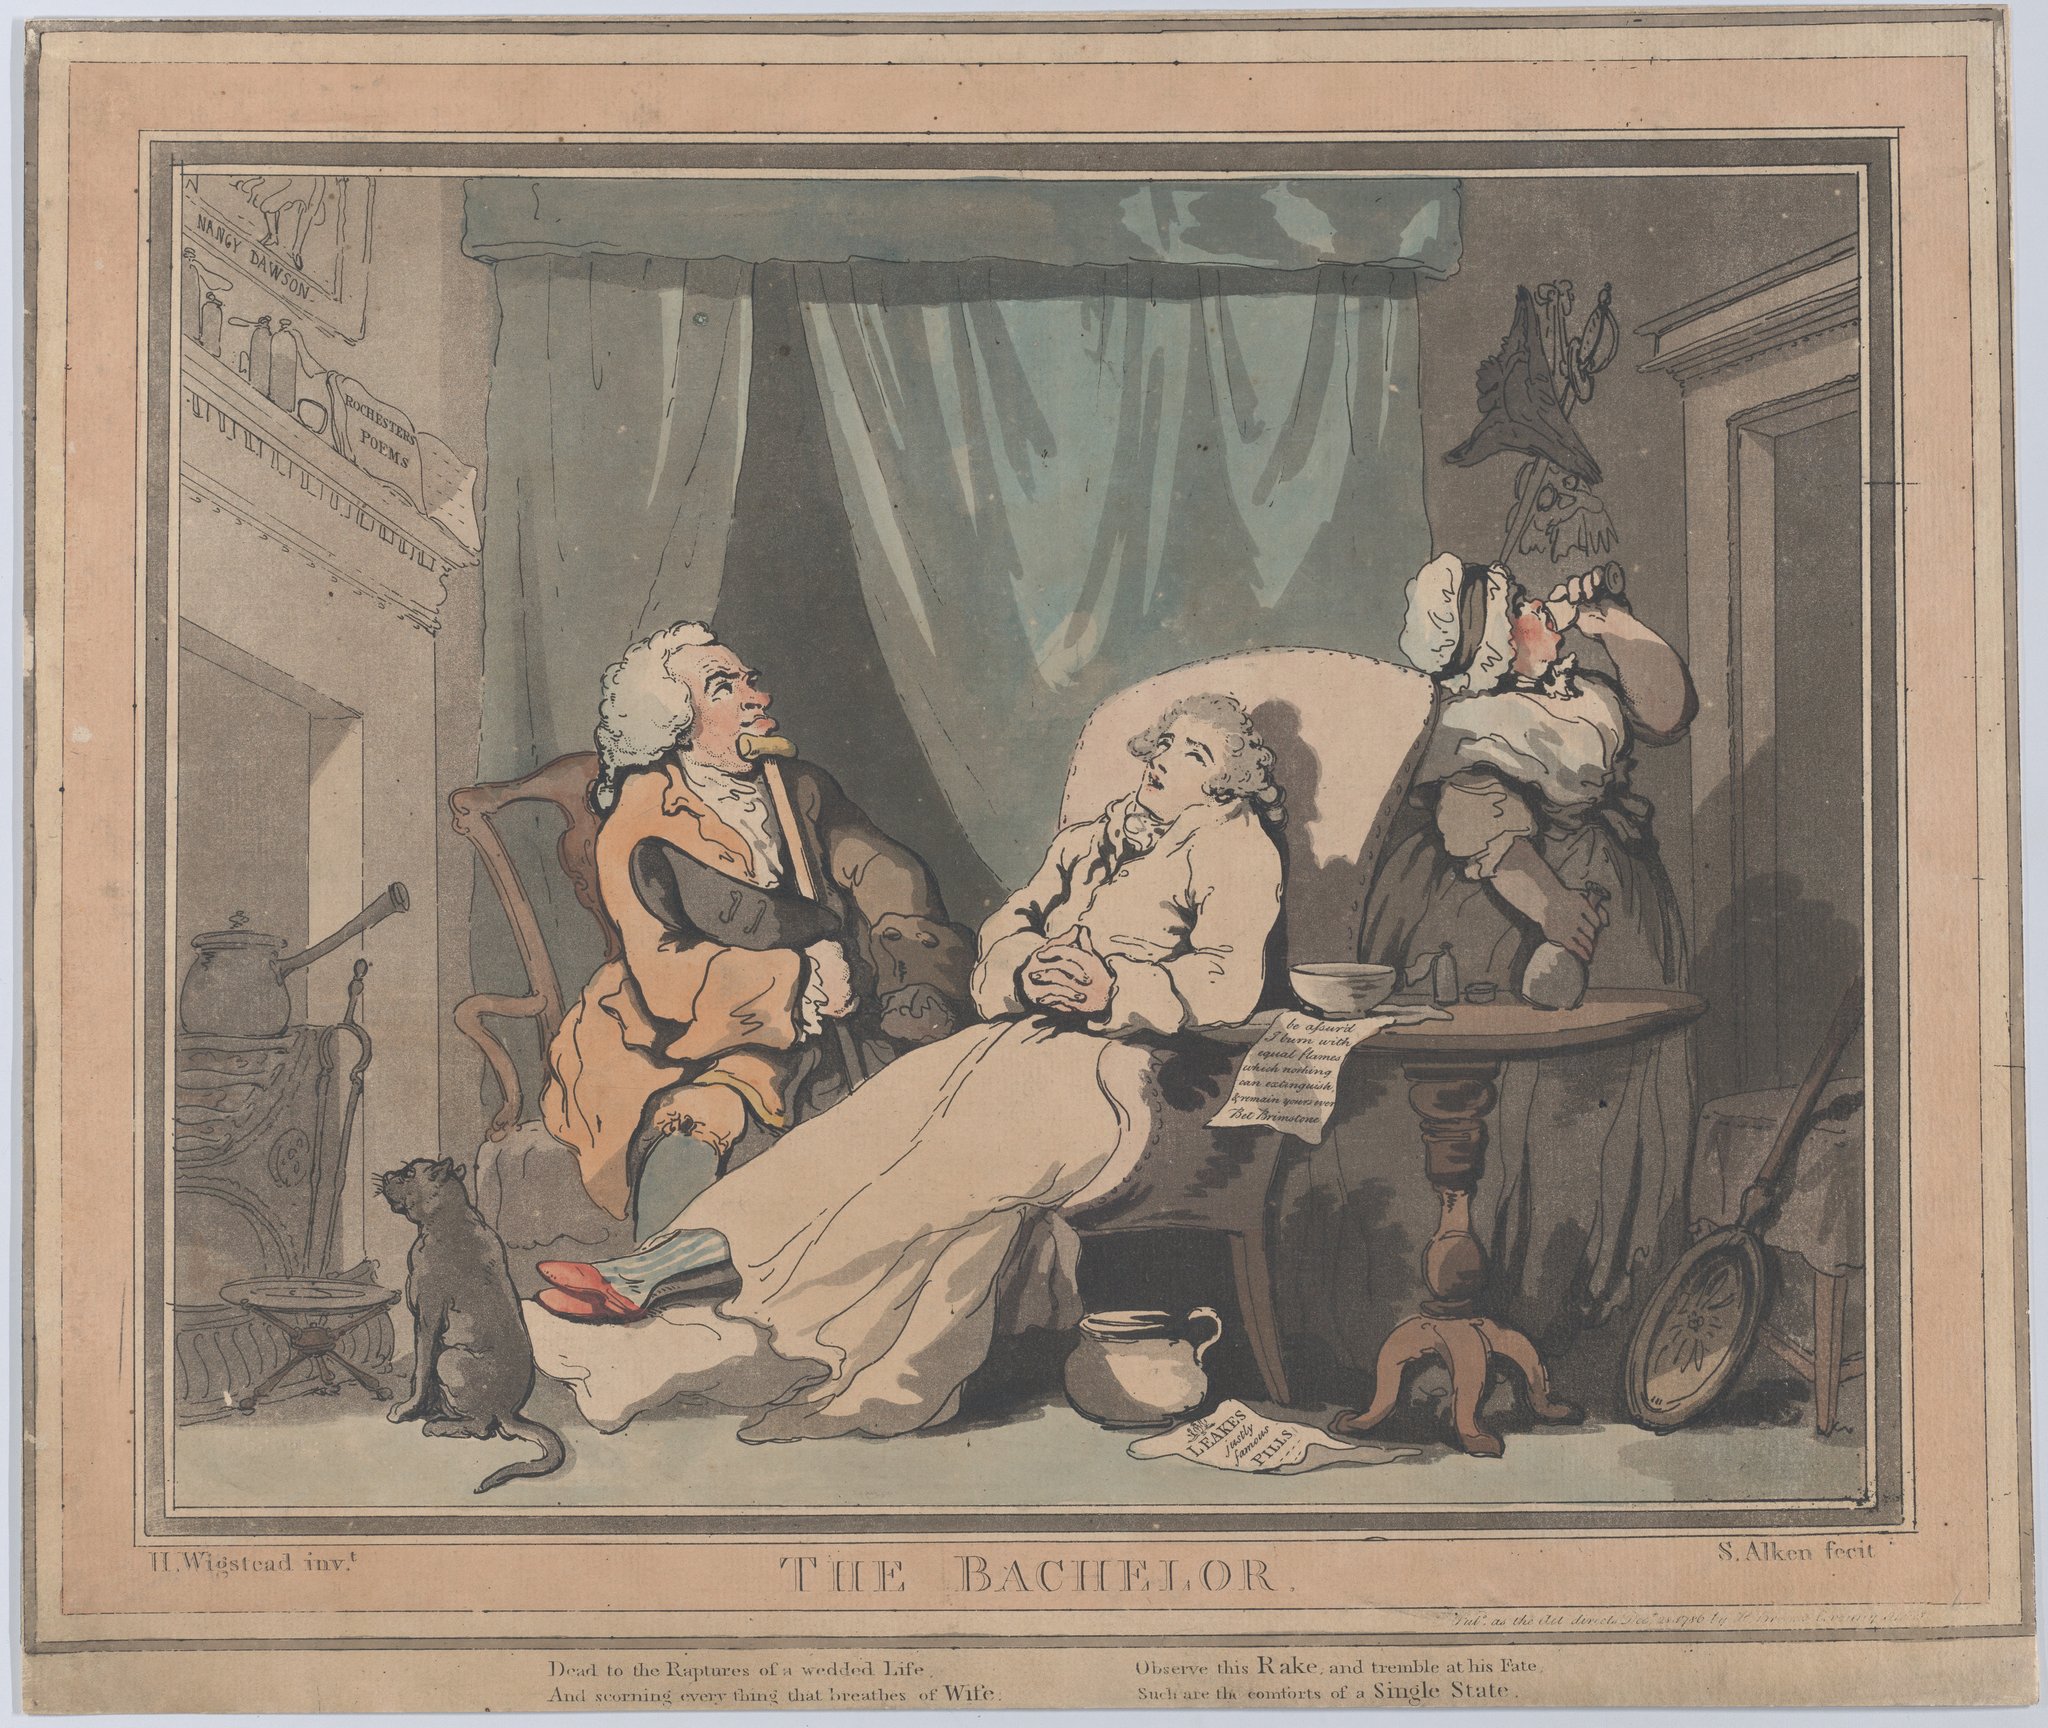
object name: print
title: The Bachelor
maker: samuel alken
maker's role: etcher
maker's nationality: british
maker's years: 1756-1815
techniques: aquatint, etching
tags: satire,men,women,cats,drinking